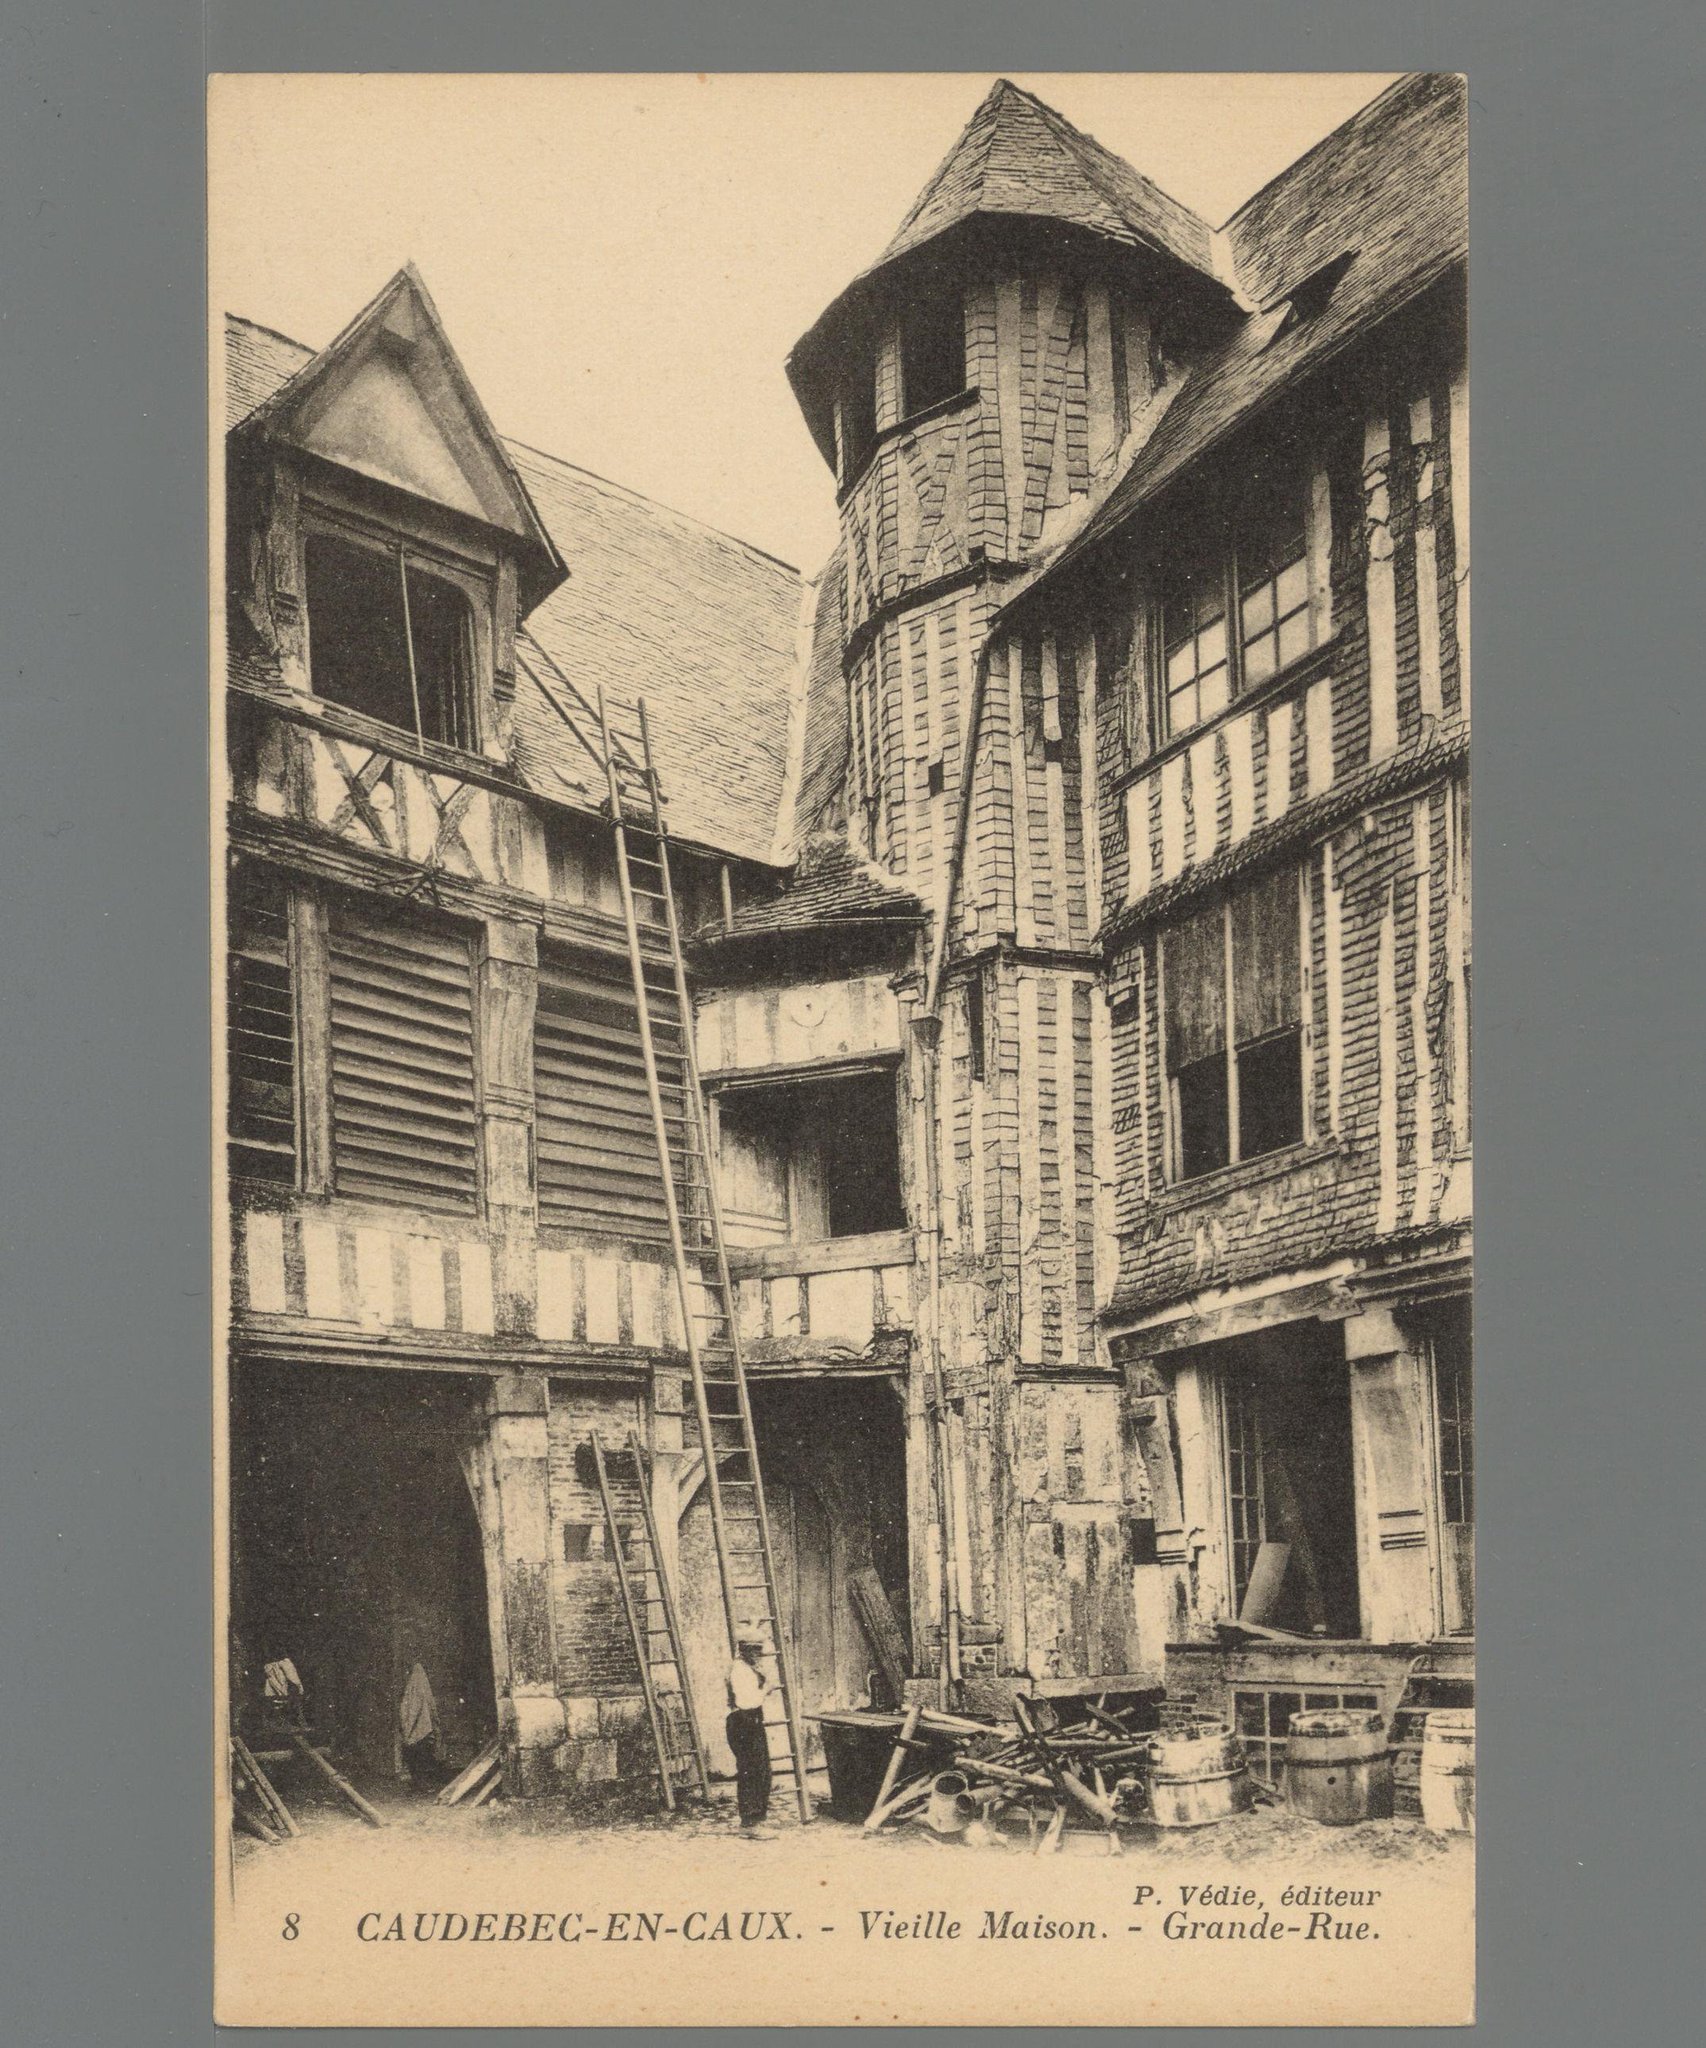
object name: photomechanical print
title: Caudebec-en Caux. Vieille Maison. Grande Rue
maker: p. védie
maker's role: publisher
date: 1920-1932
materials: cardboard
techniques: photograph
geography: paris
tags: parts (of house or building), ladder